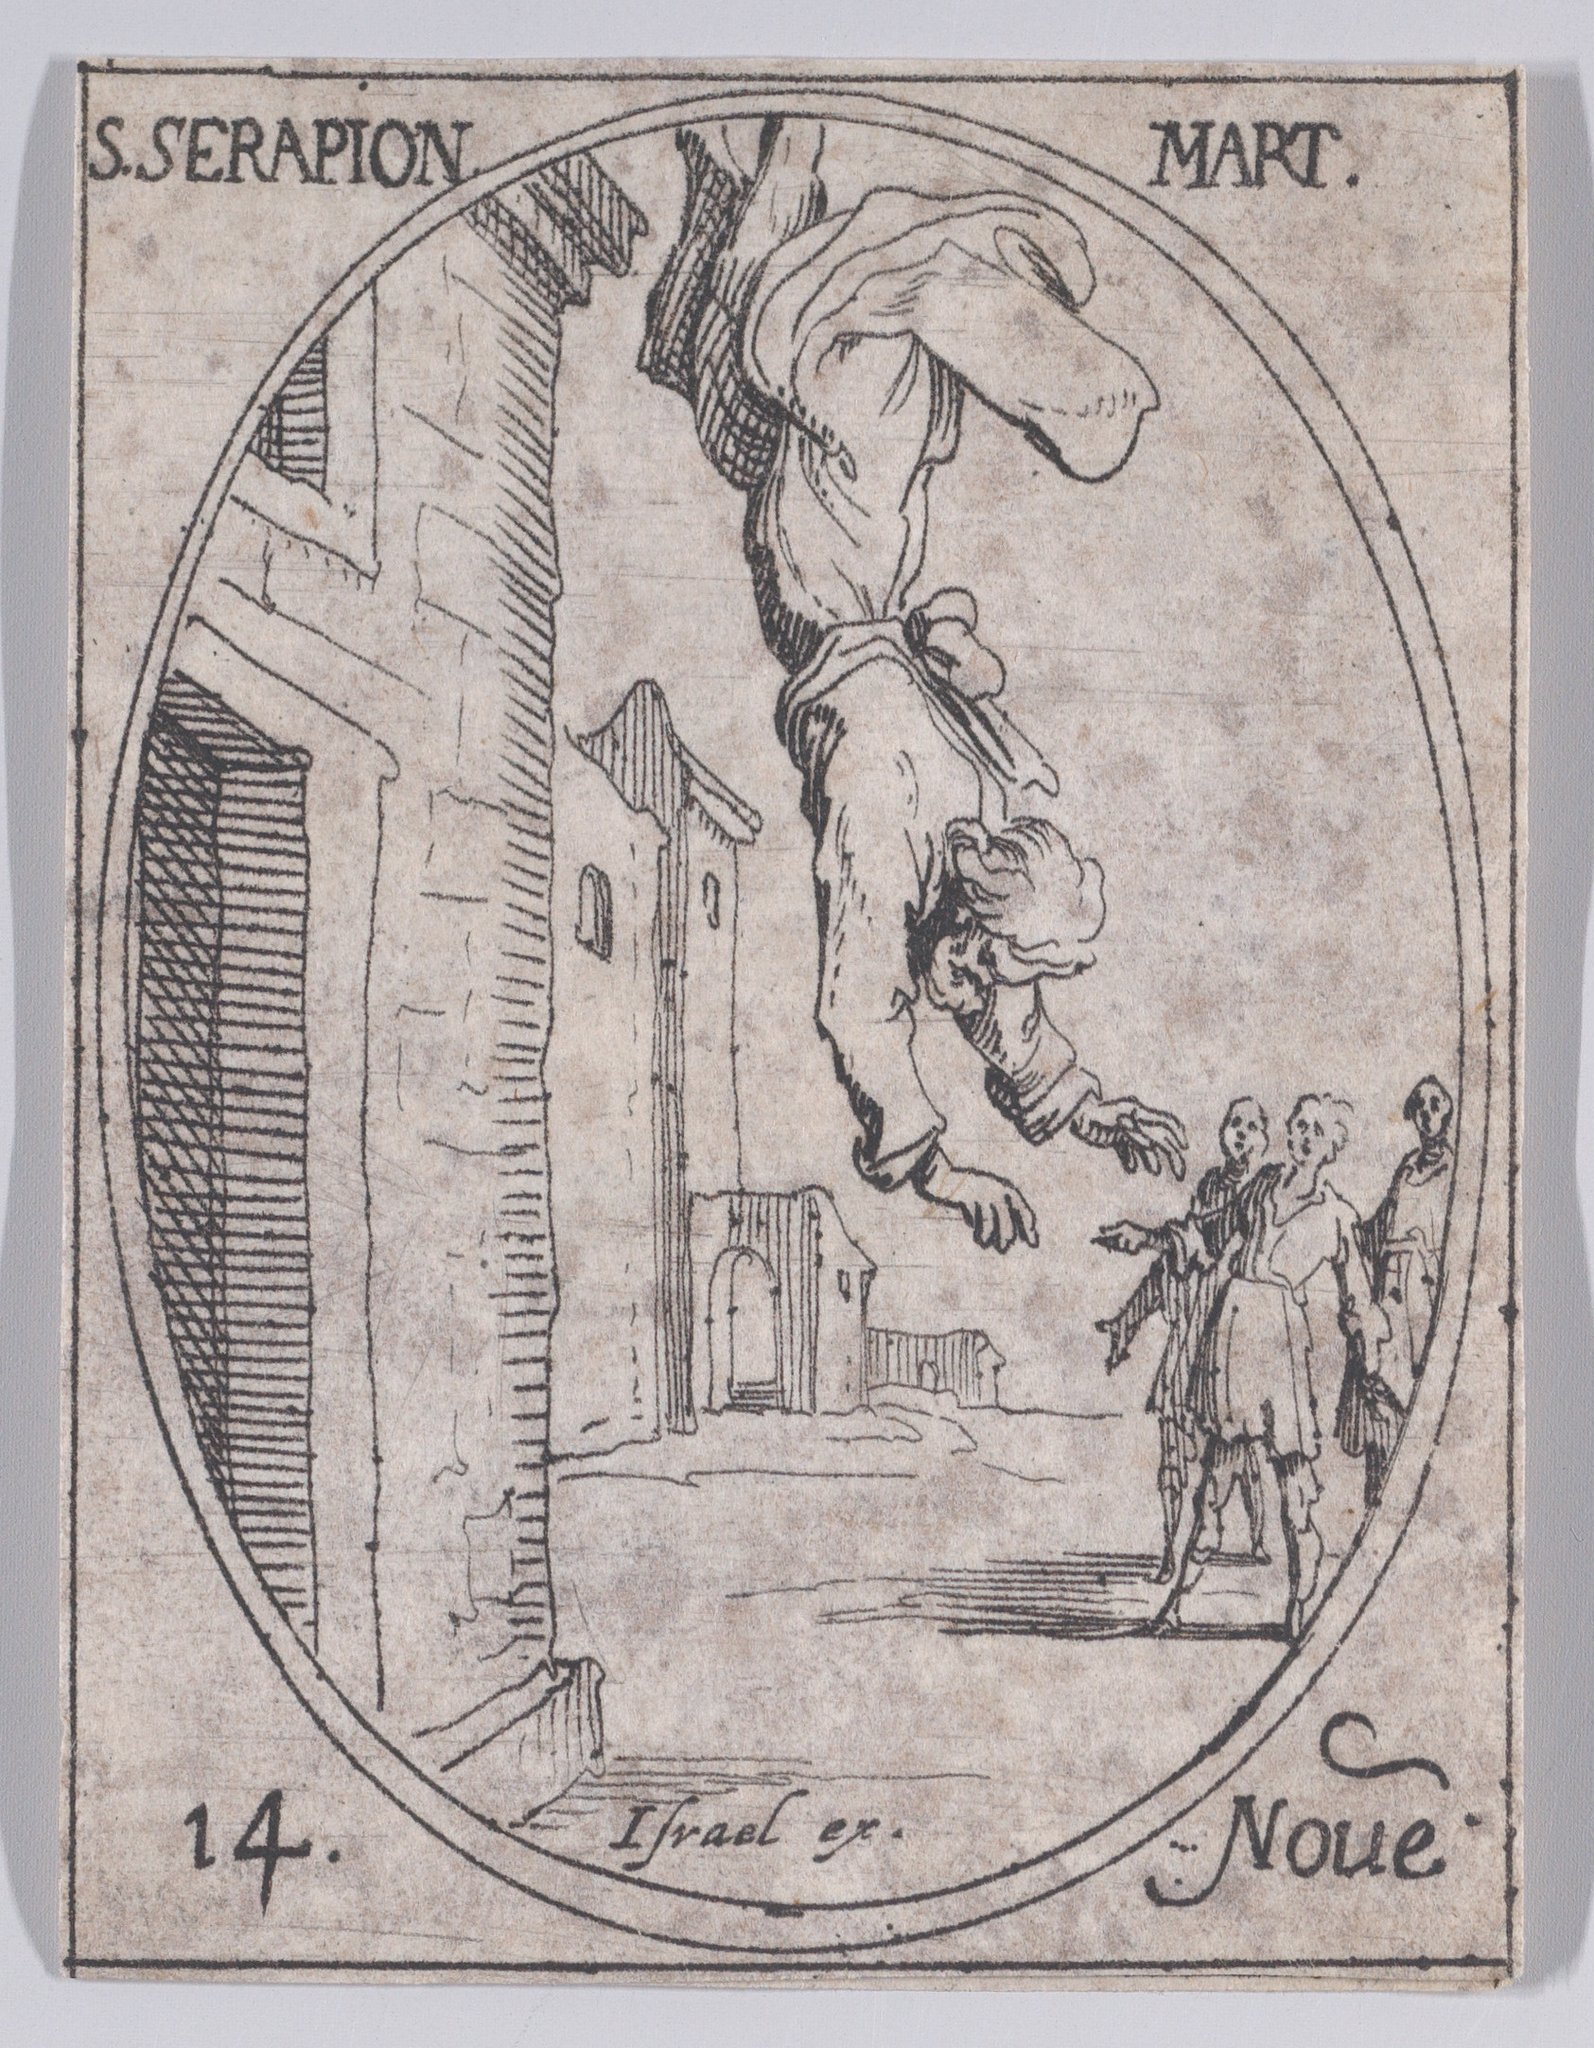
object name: print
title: St. Serapion, Martyr, November 14th, from "Les Images De Tous Les Saincts et Saintes de L'Année" (Images of All of the Saints and Religious Events of the Year)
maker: jacques callot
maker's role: artist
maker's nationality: french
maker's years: 1592-1635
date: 1636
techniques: etching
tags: men,saints